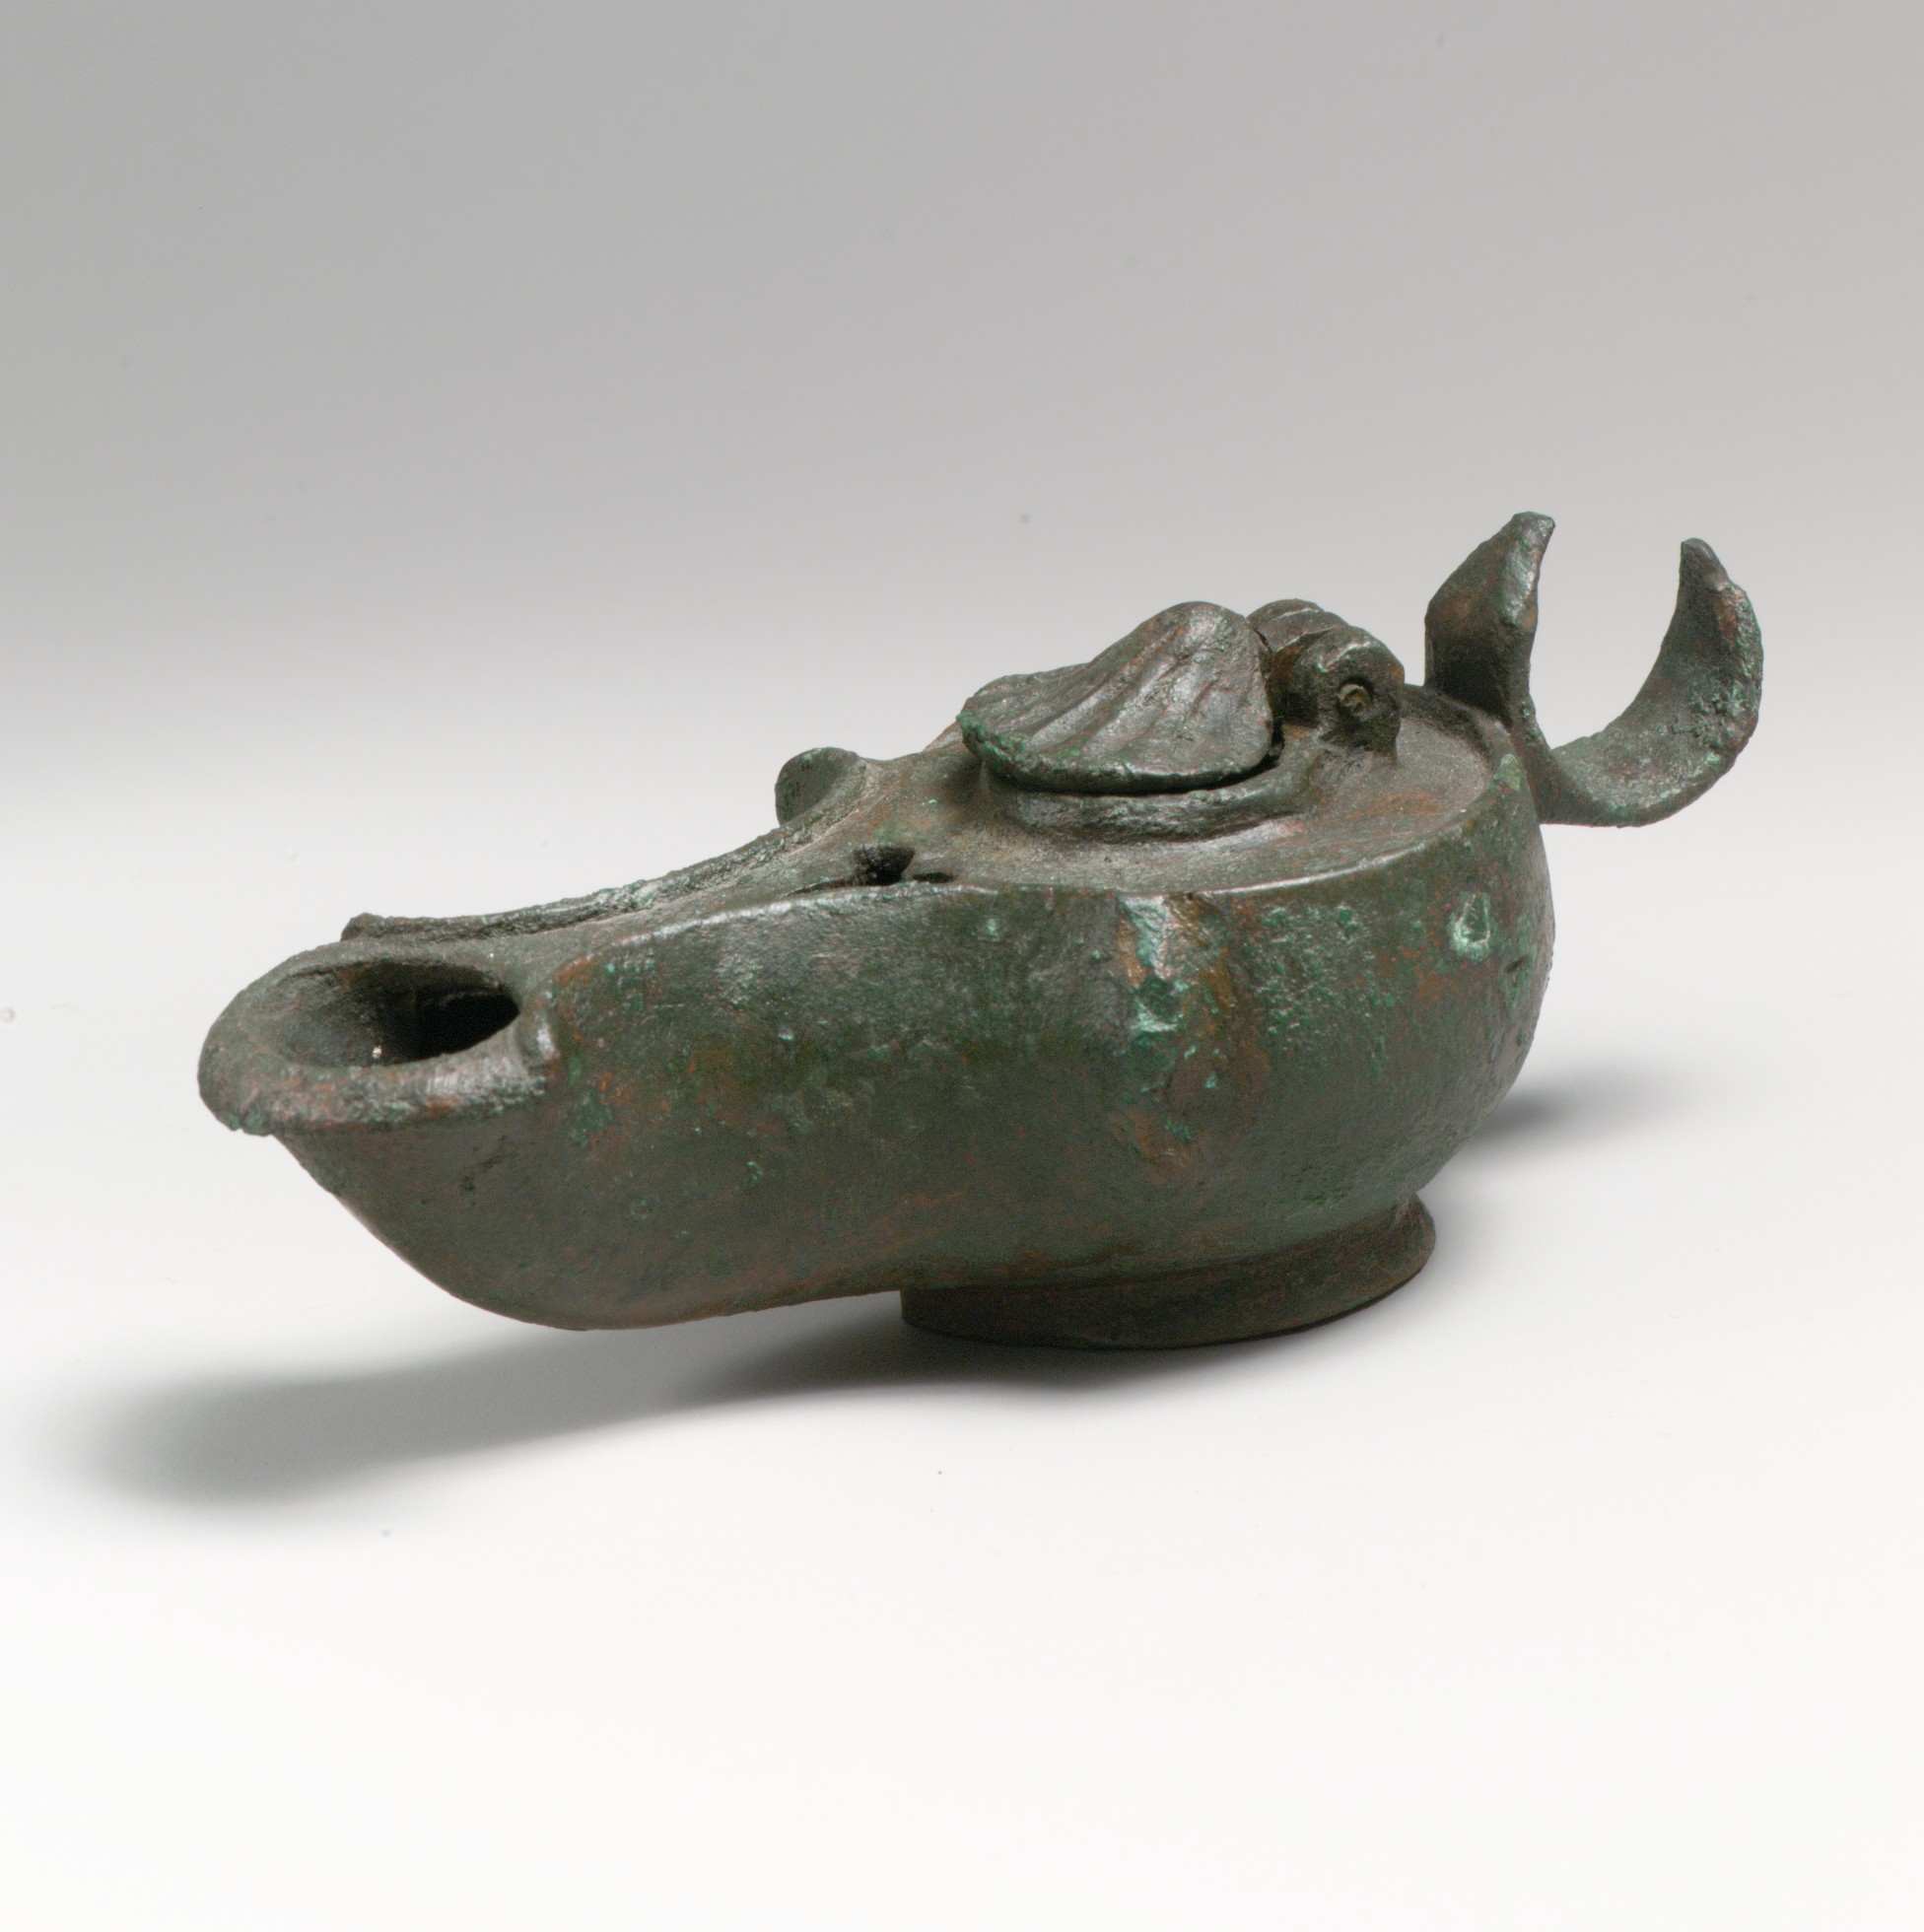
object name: lamp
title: Bronze lamp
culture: roman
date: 1-200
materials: bronze